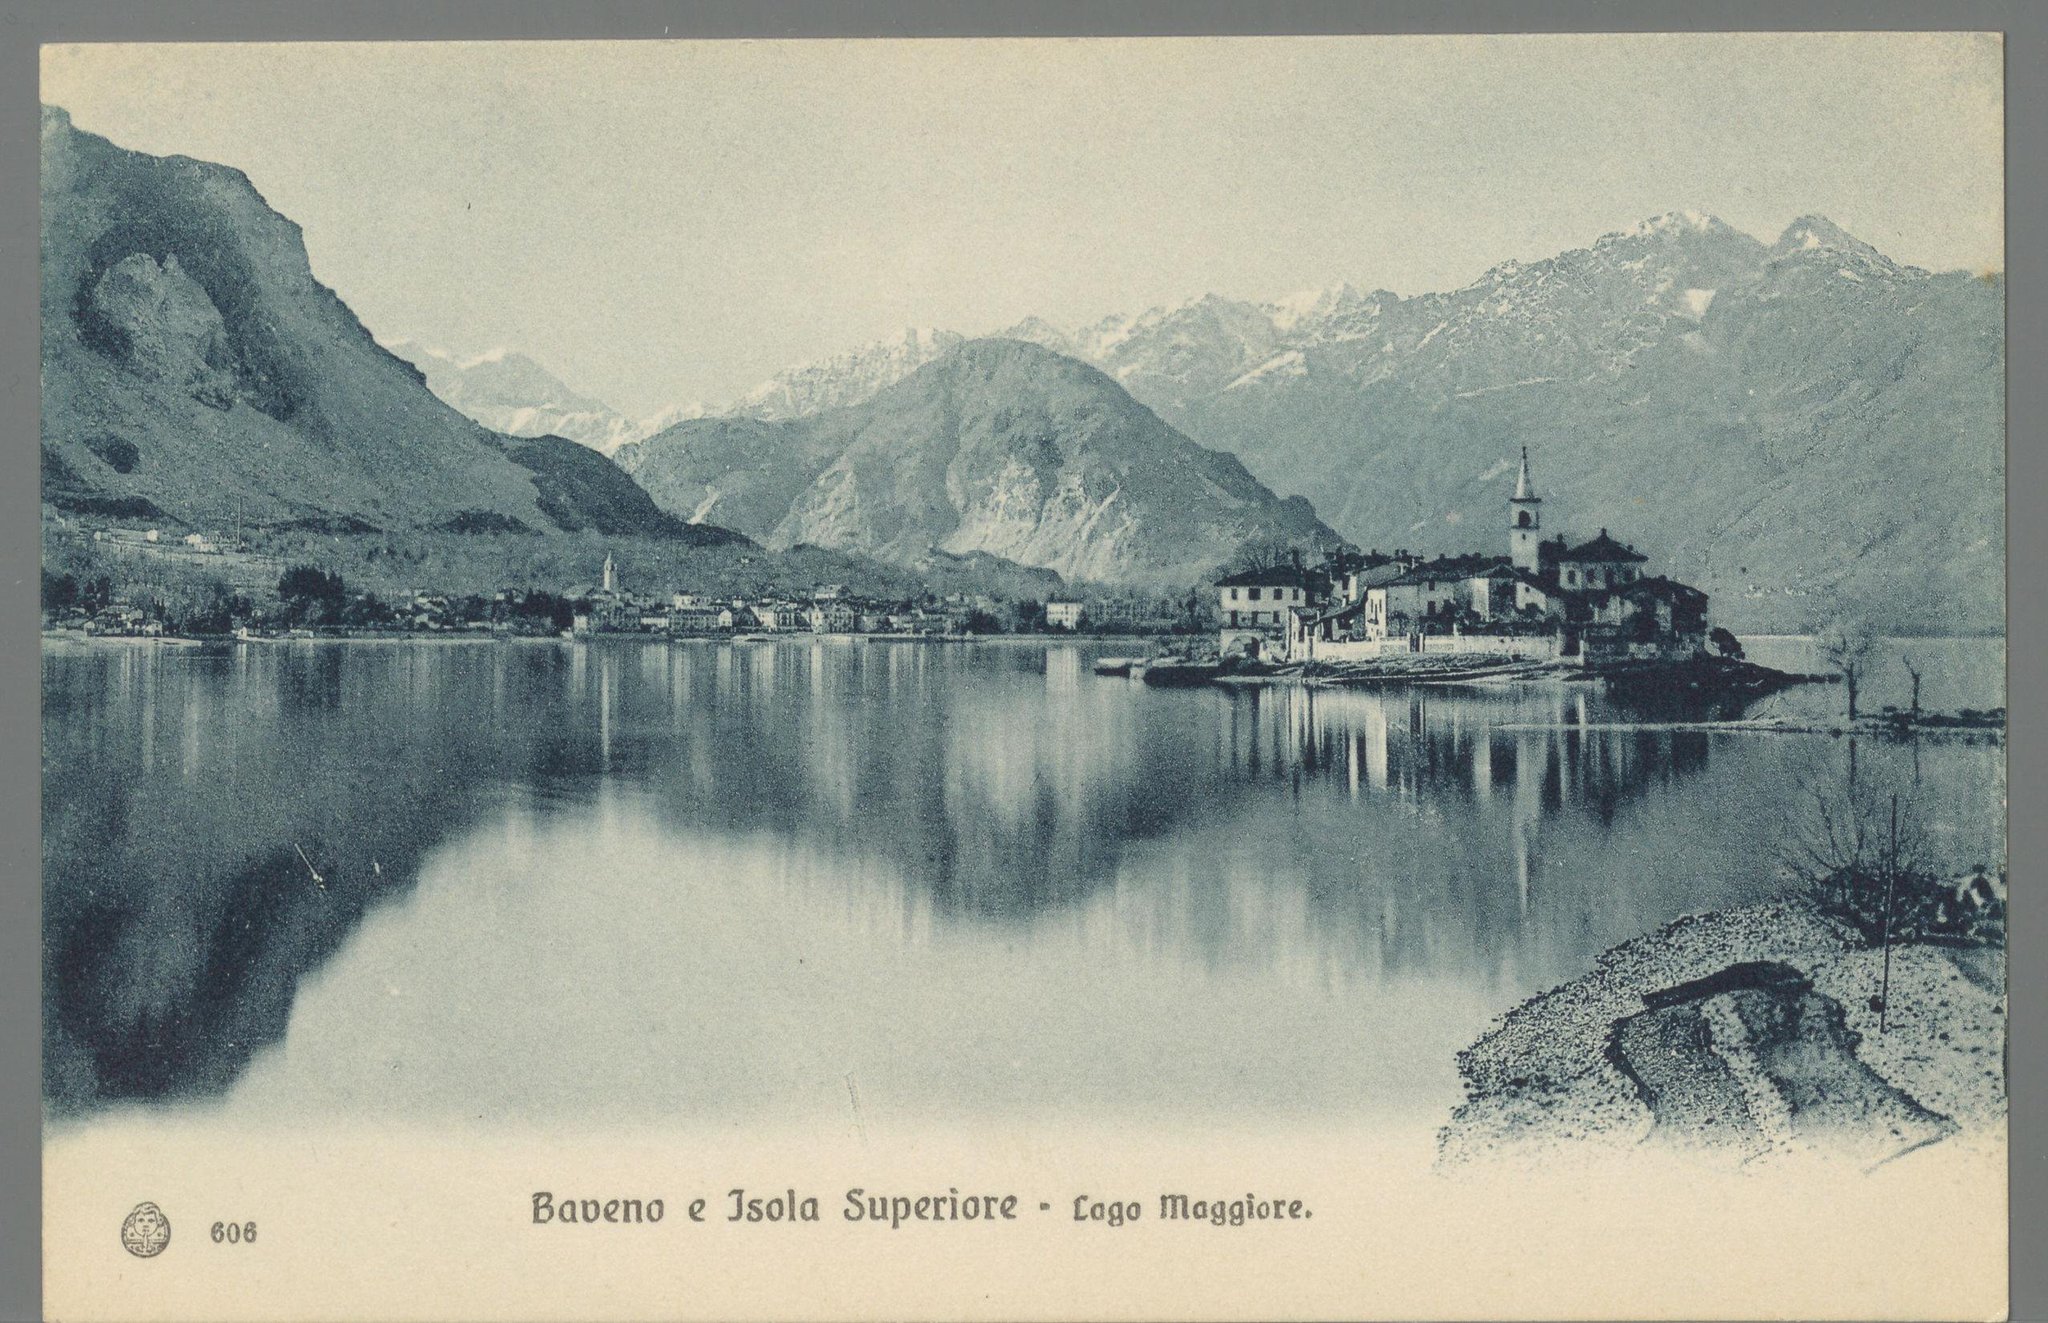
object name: ansichtkaart, prentbriefkaart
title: Baveno e Isola Superiore. Lago Maggiore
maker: Anonymous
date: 1905-1930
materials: cardboard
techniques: photograph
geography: zurich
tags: village, lake, mountains